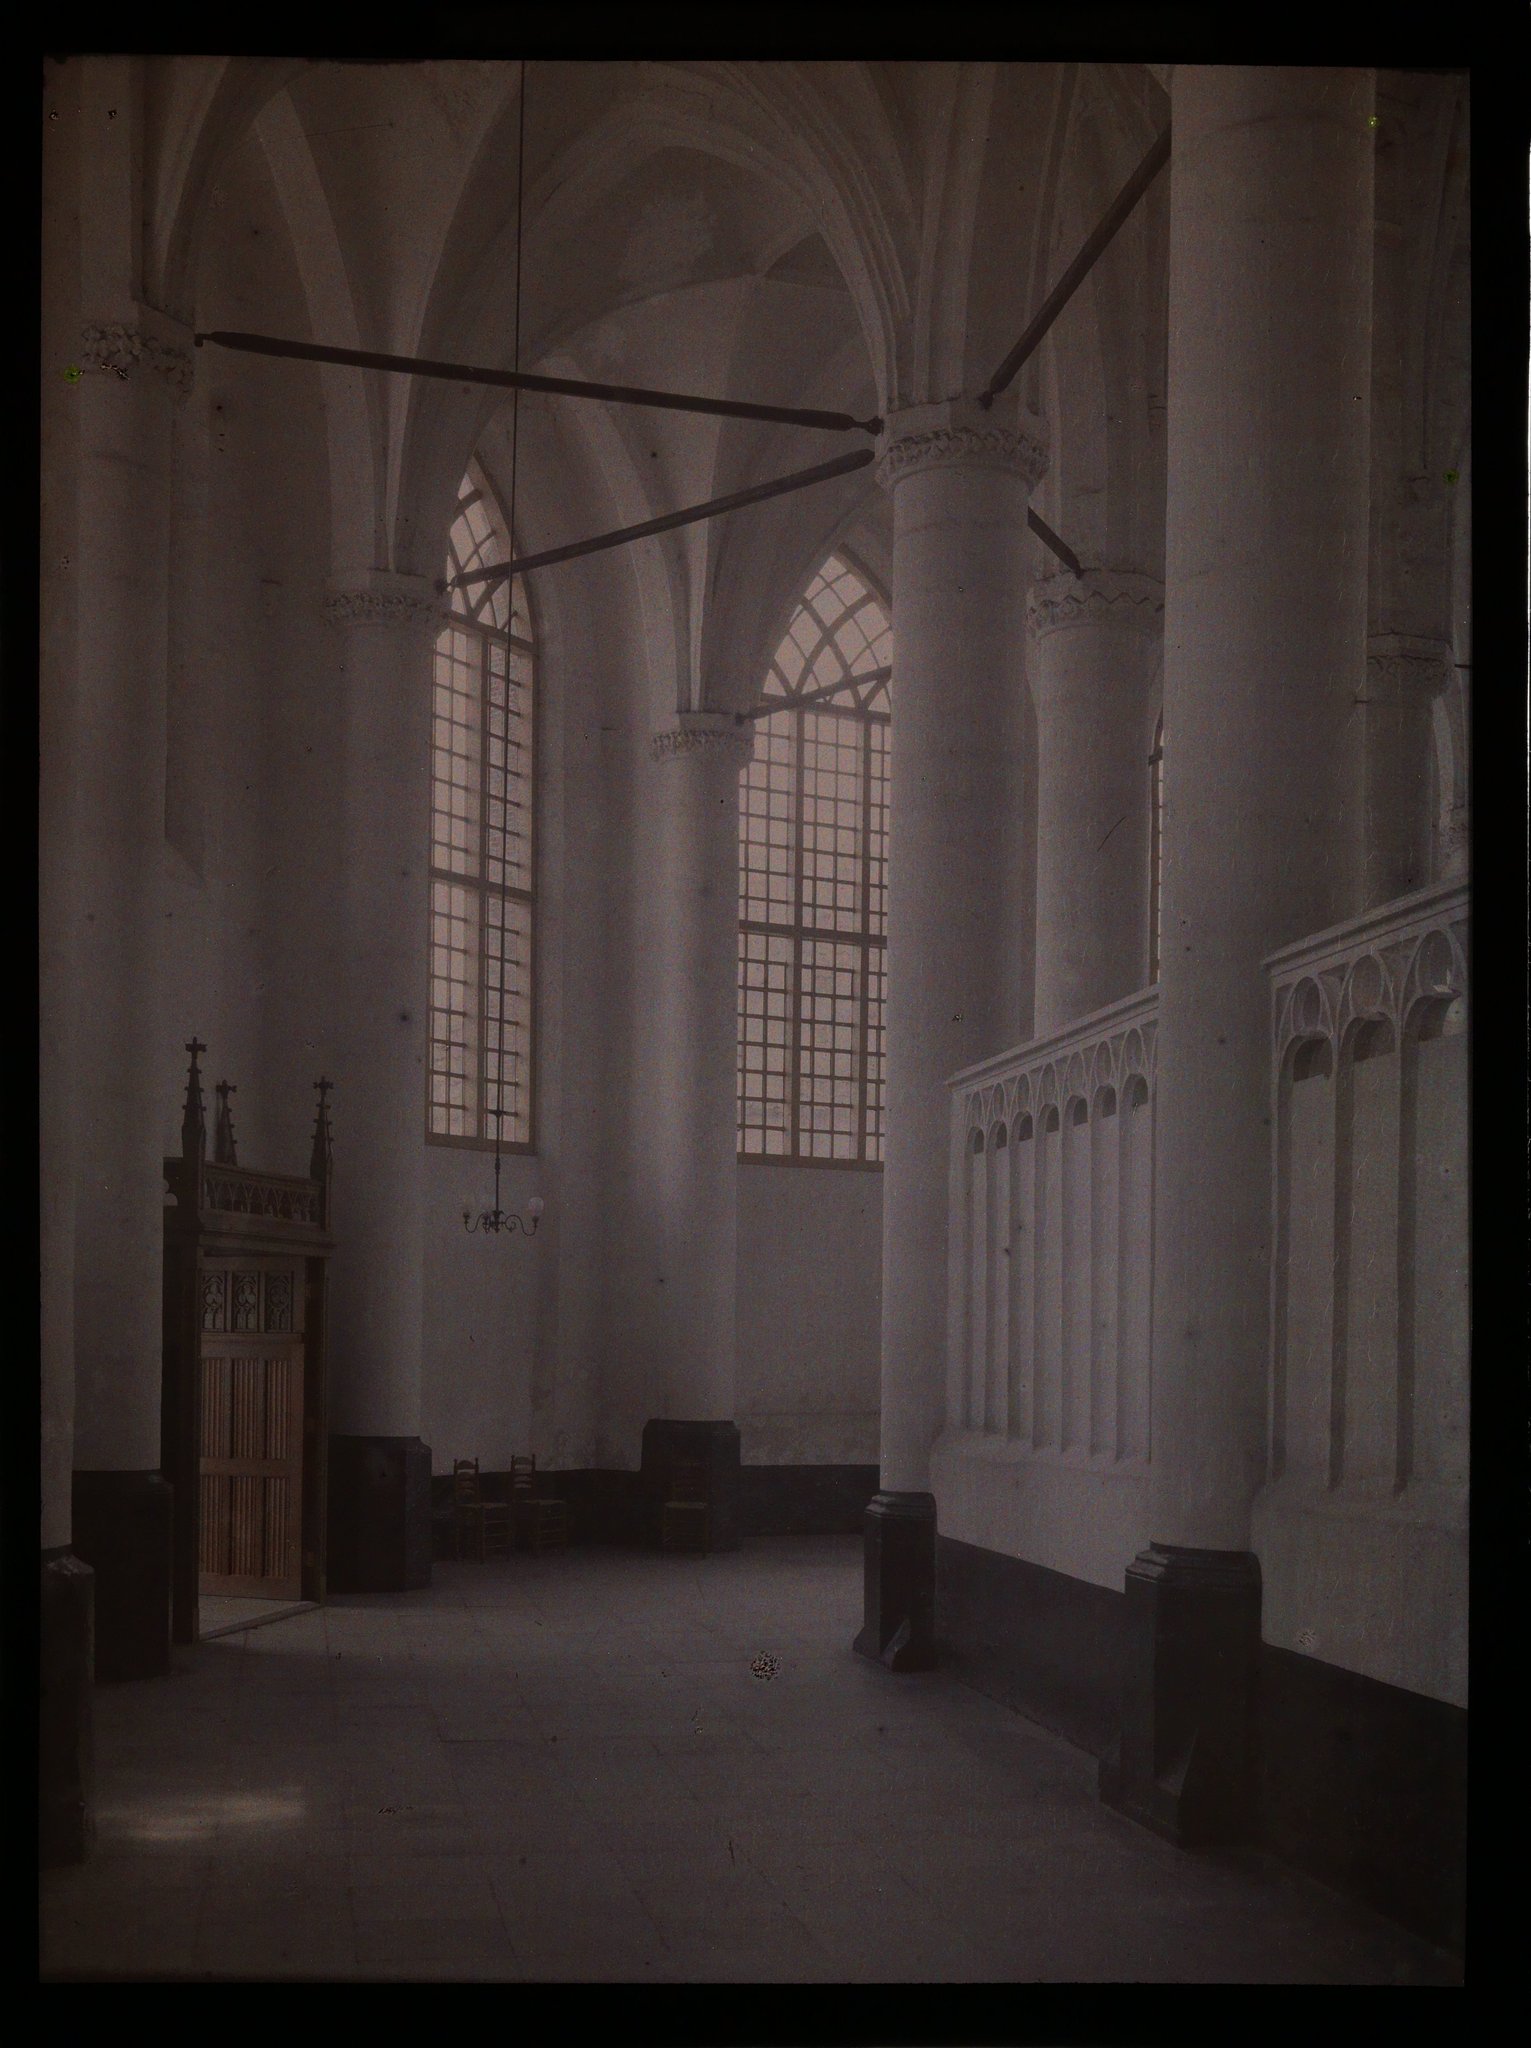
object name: photograph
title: Kerkinterieur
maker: Anonymous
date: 1907-1935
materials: glass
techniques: autochrome process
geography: netherlands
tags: interior of church, netherlands